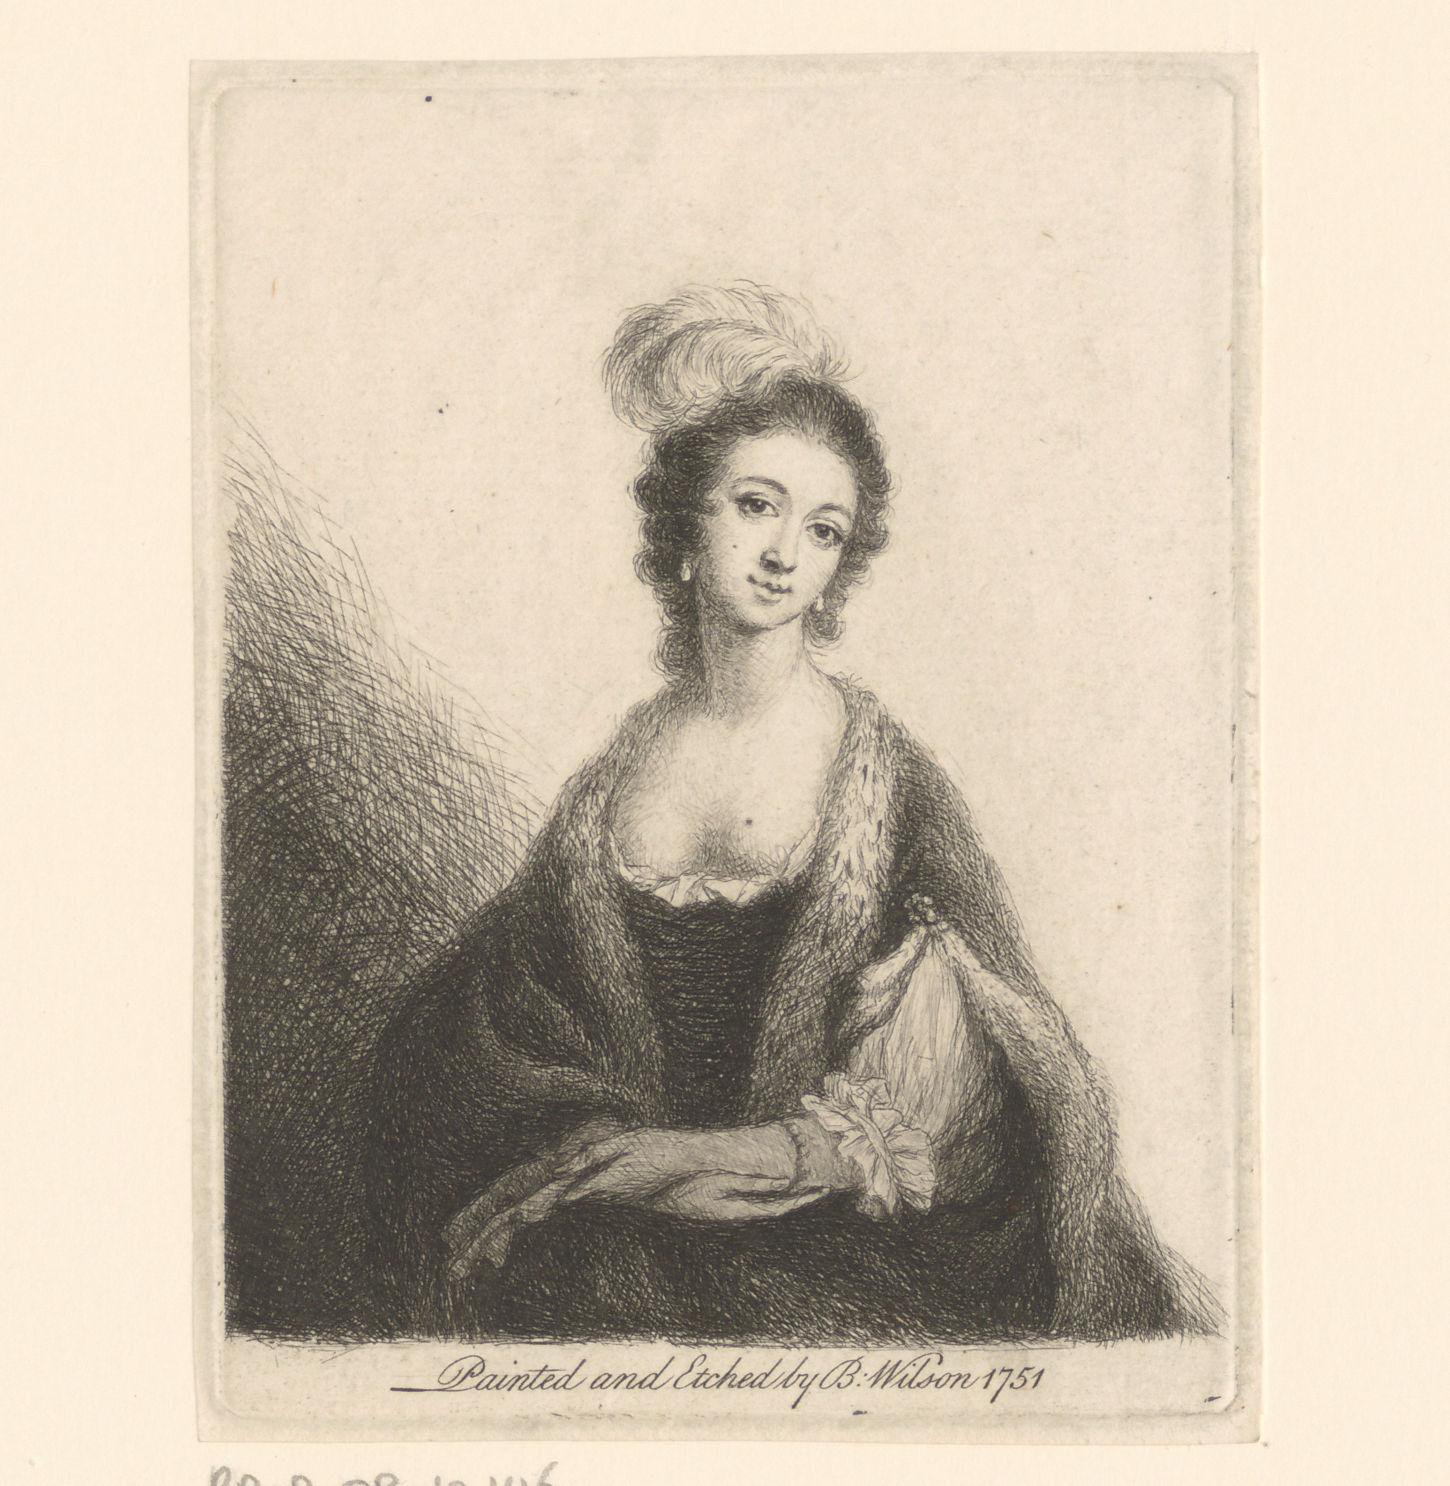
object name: print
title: Portret van Maria Coventry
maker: benjamin wilson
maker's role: painter, print maker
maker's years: 1721-1788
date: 1751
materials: paper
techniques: etching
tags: historical persons - bb - woman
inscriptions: collector's mark: Lugt 2228